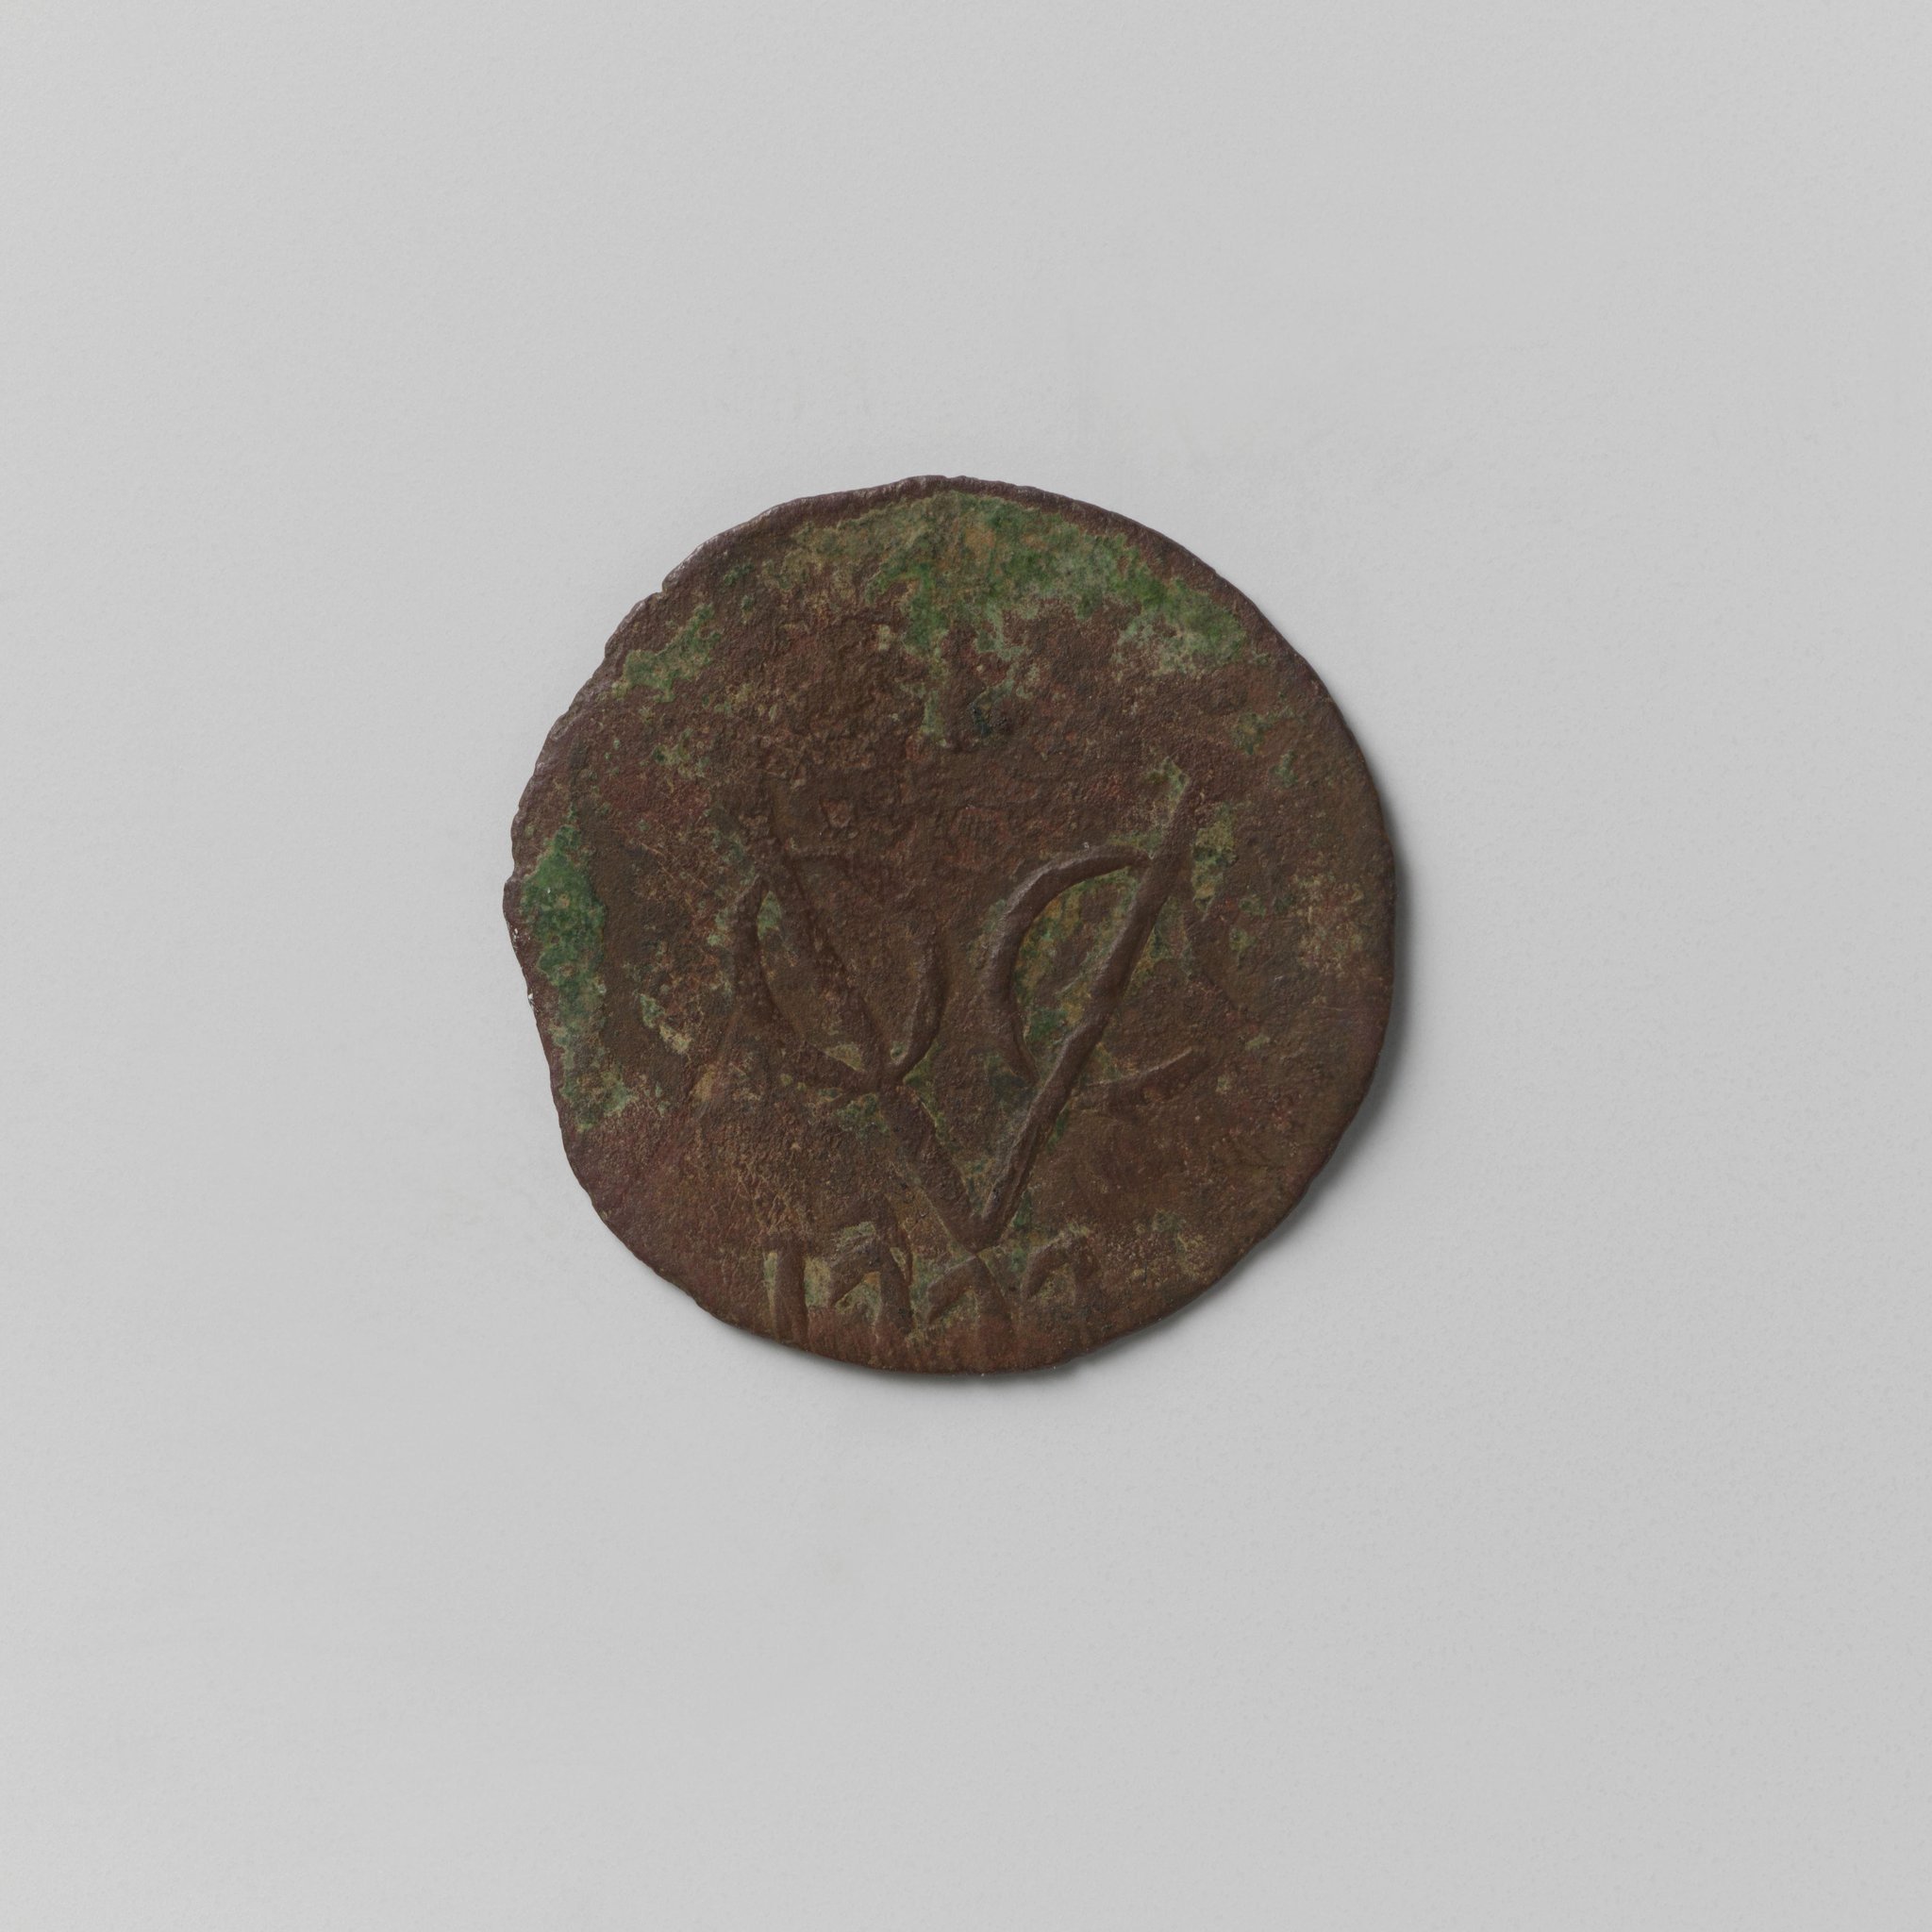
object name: coin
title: Nabootsing van VOC- duit Holland, 1777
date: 1777-1830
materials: copper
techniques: striking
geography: banjarmasin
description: Koperen munt. Nabootsing van duit van de VOC uit Holland. Voorzijde: gekroond wapenschild van Holland. Keerzijde: monogram van de VOC, waarboven punt en waaronder fictief jaartal.